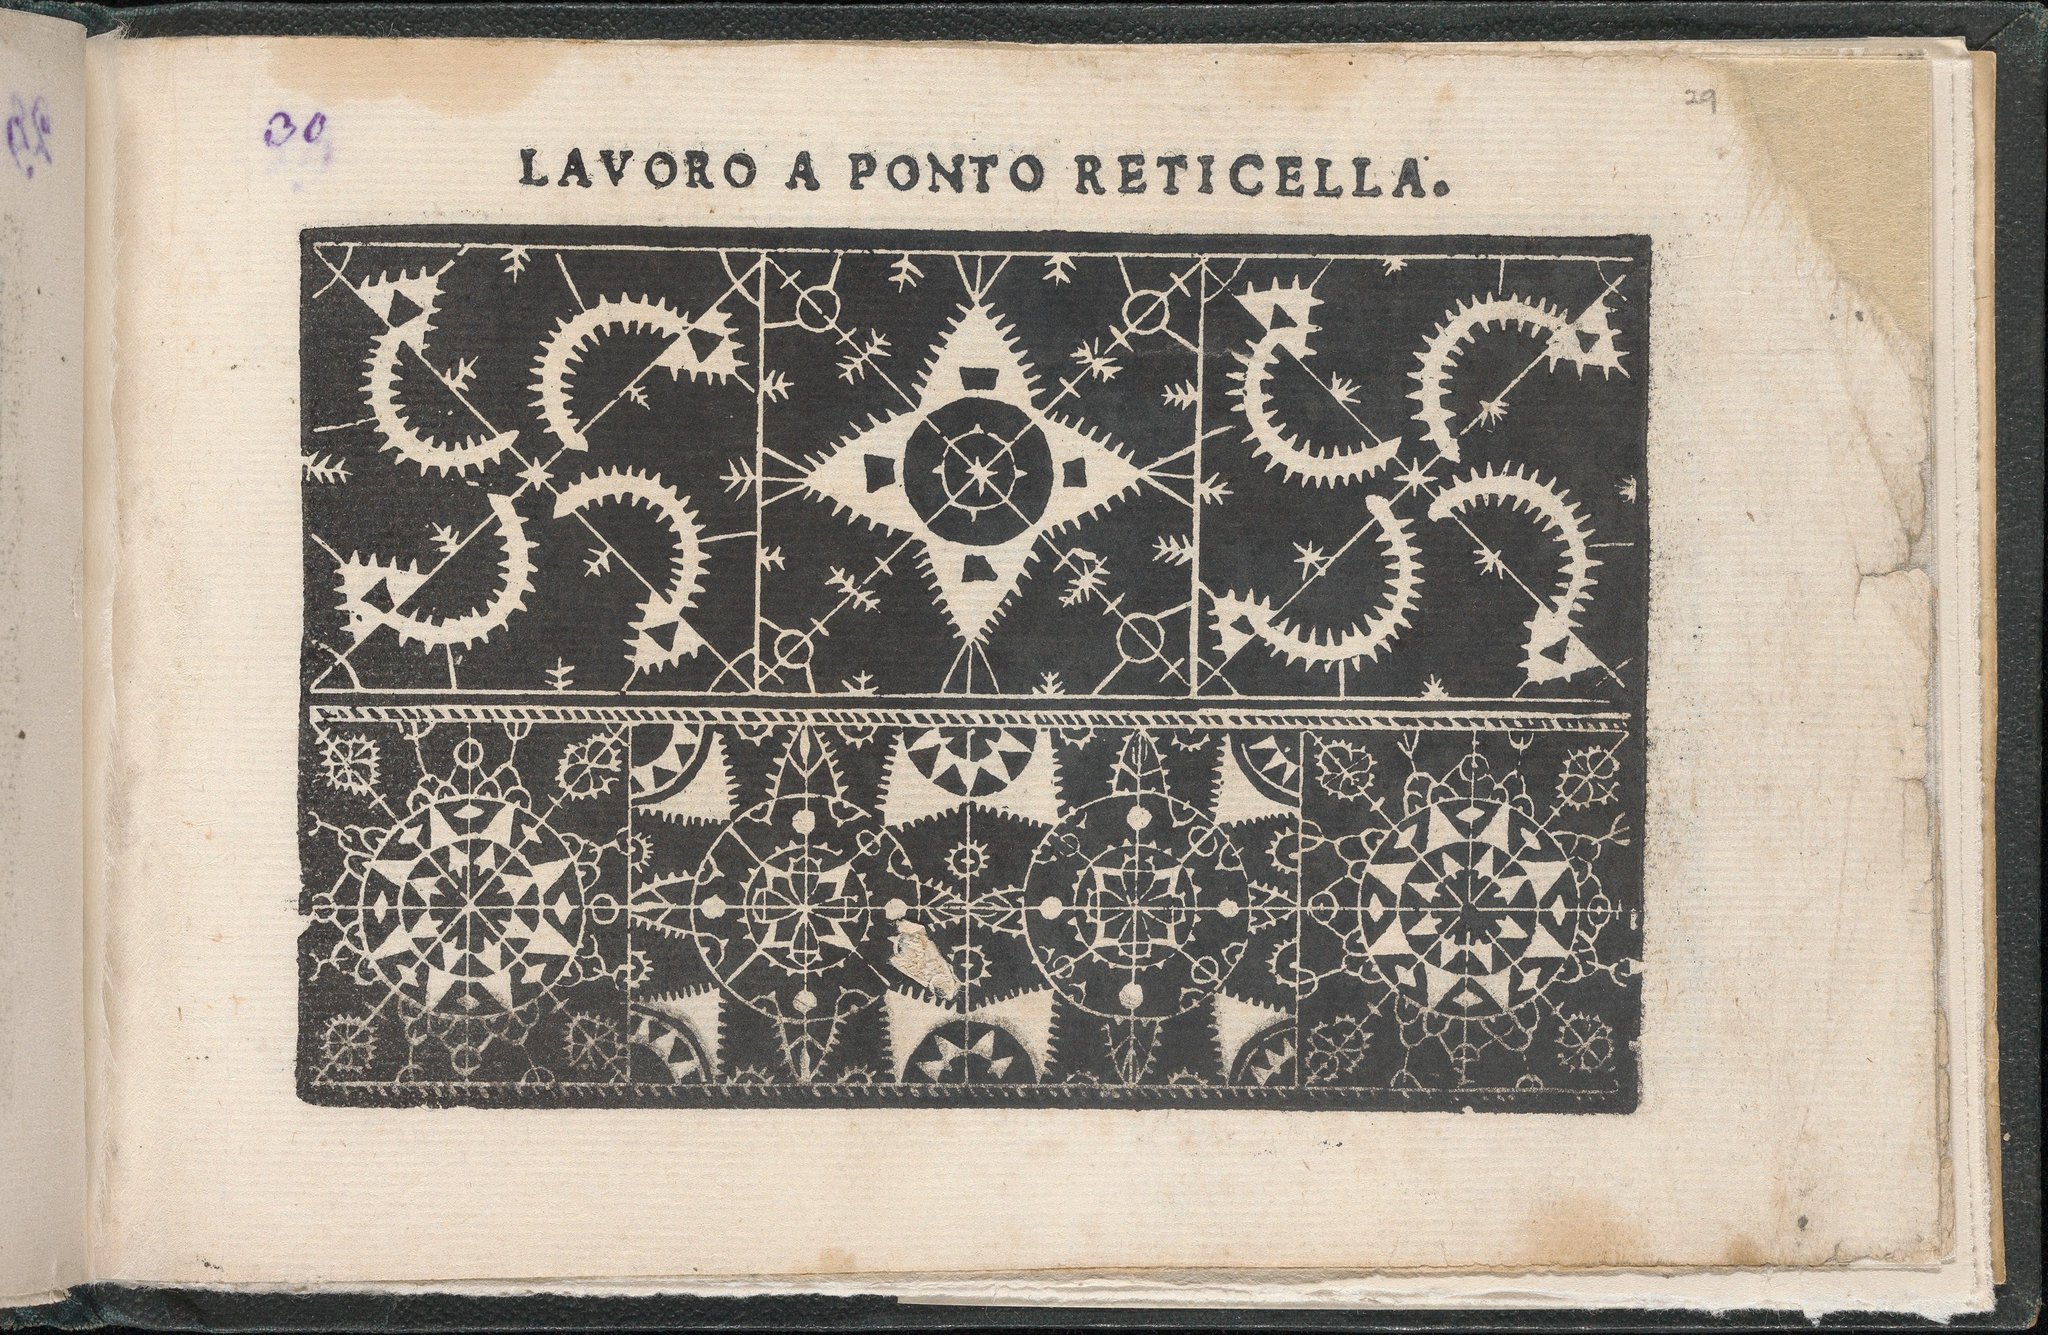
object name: book print ornament architecture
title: Gemma pretiosa della virtuose donne, page 29 (recto)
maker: isabella catanea parasole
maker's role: designer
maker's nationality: italian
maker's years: 1565-1625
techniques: woodcut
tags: ornament